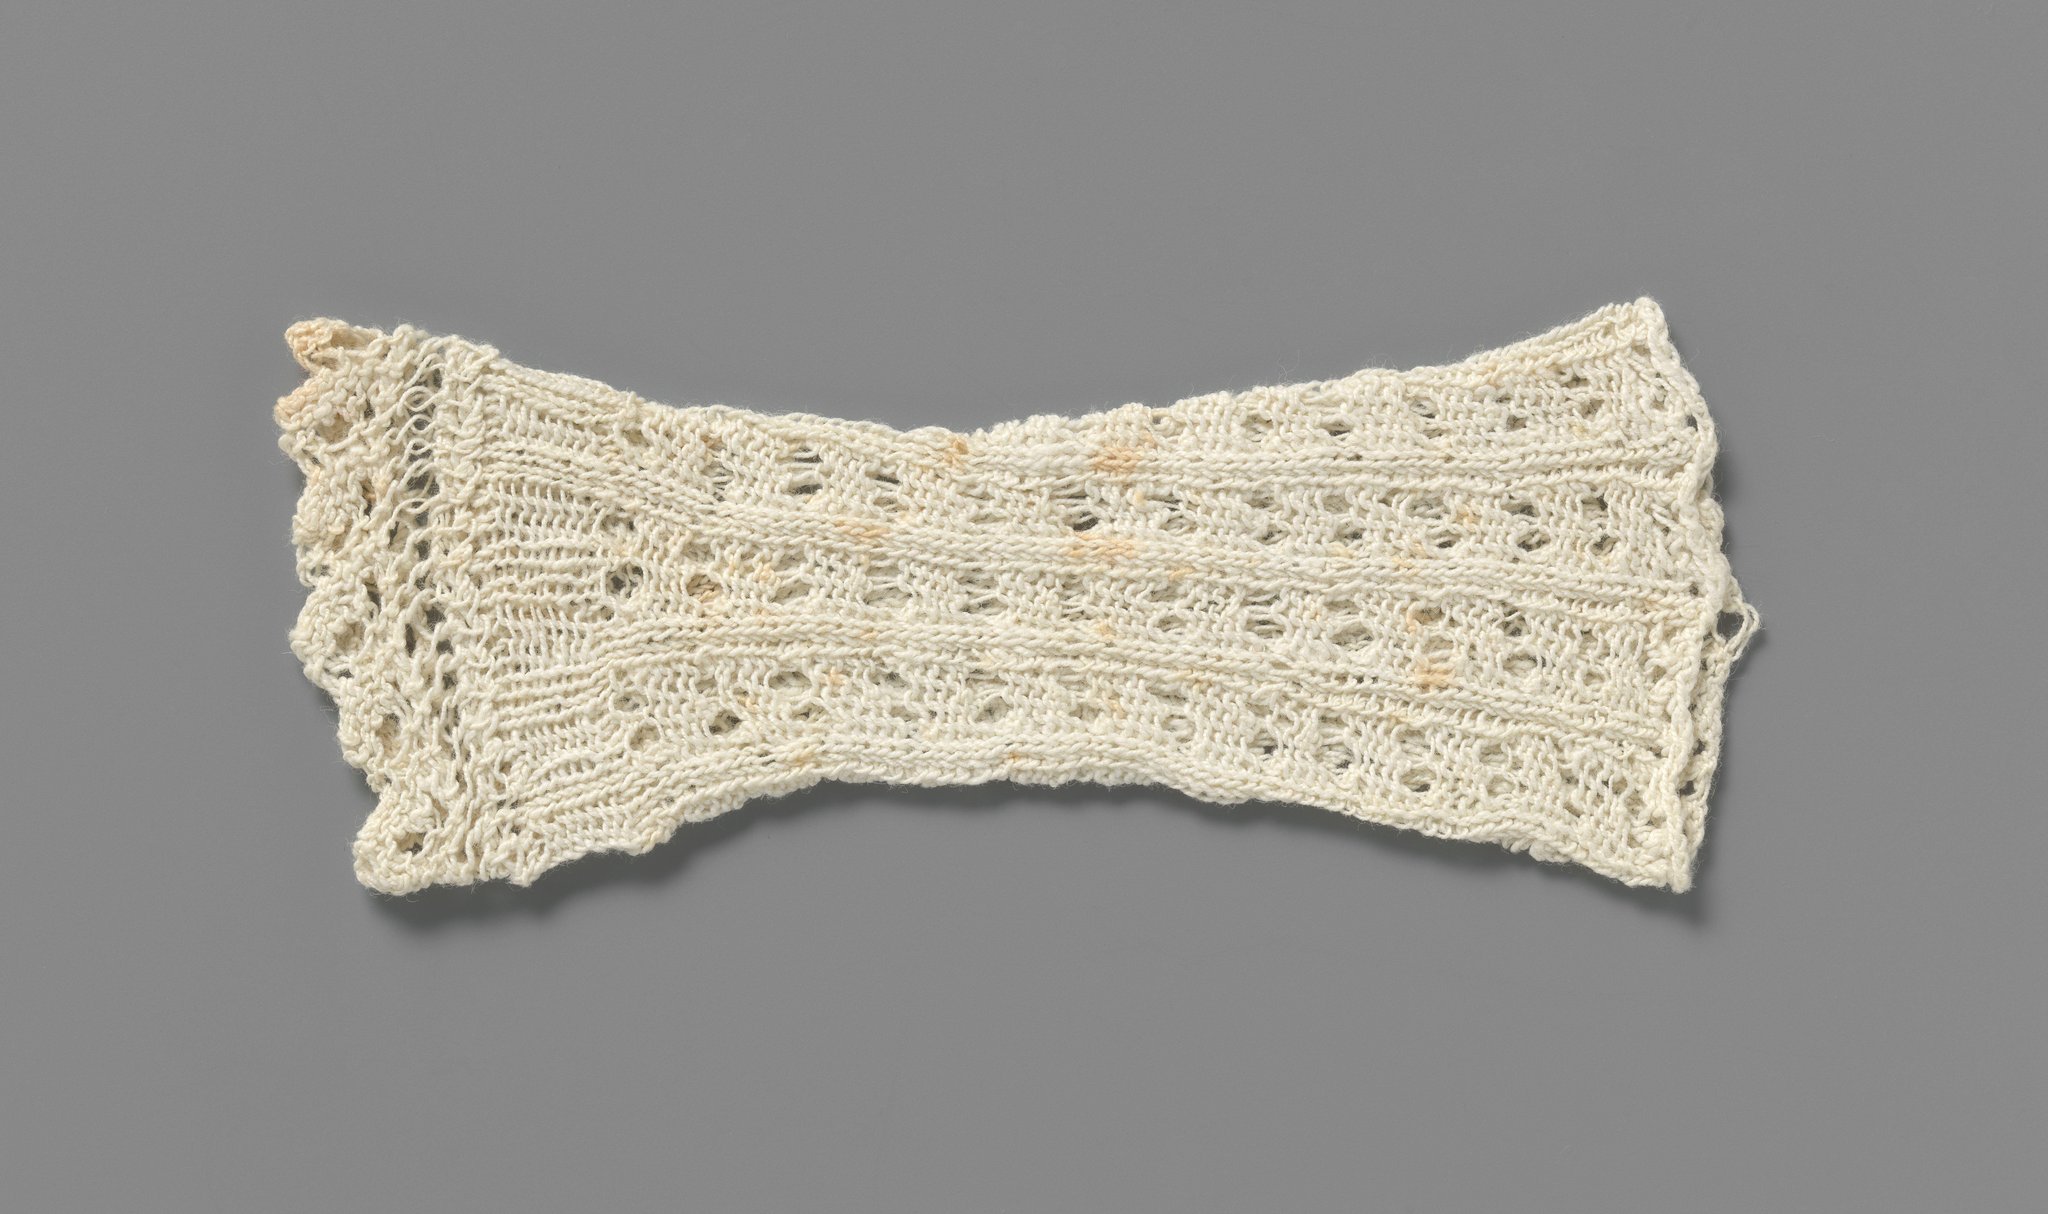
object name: mitt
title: Mitaine van witte gebreide katoen in ajour patroon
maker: Anonymous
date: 1800-1825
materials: cotton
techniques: knitting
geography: netherlands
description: Mitaine van witte gebreide katoen in ajour patroon van verticale strepen waartussen gaten en ribbels, de bovenzijde geschulpt, aan de onderzijde gaatjesrand voor een rijglint, voor baby of kind